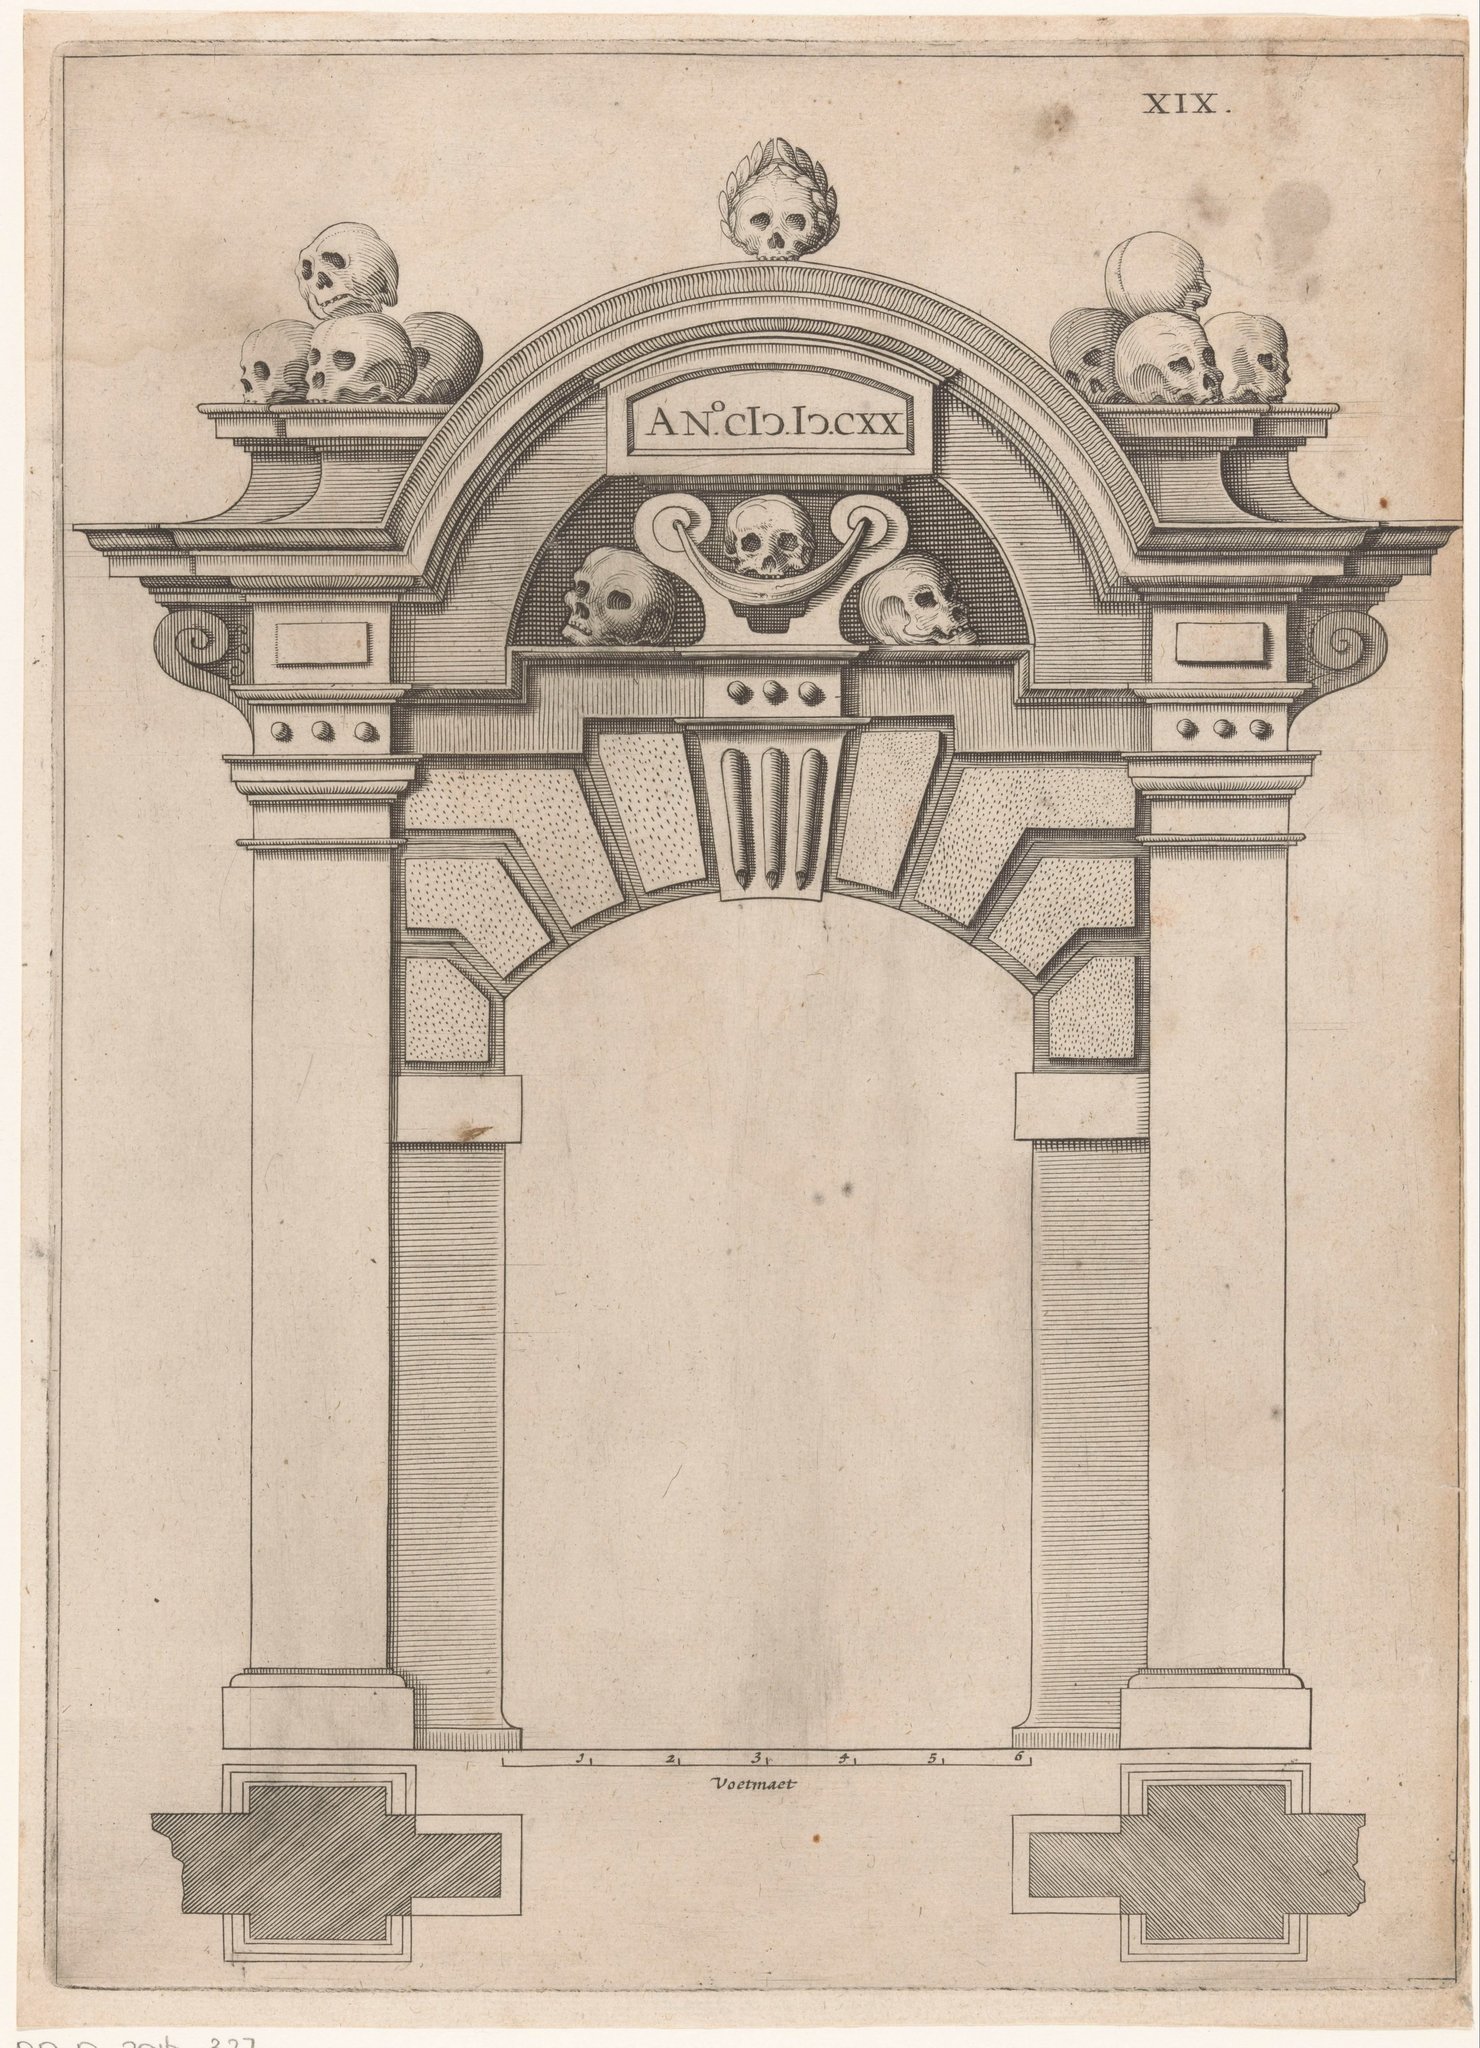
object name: book illustration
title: Poort tot begraafplaats bij de Westerkerk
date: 1631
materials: paper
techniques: engraving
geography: amsterdam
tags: churchyard, cemetery, plan ~ architecture, exterior ~ architectural design or model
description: Prent uit: Keyser, Hendrick de. Architectura moderna ofte bouwinge van onsen tyt (...) alle gedaen by (...) Amsterdam: Danckerts, Cornelis, 1631.